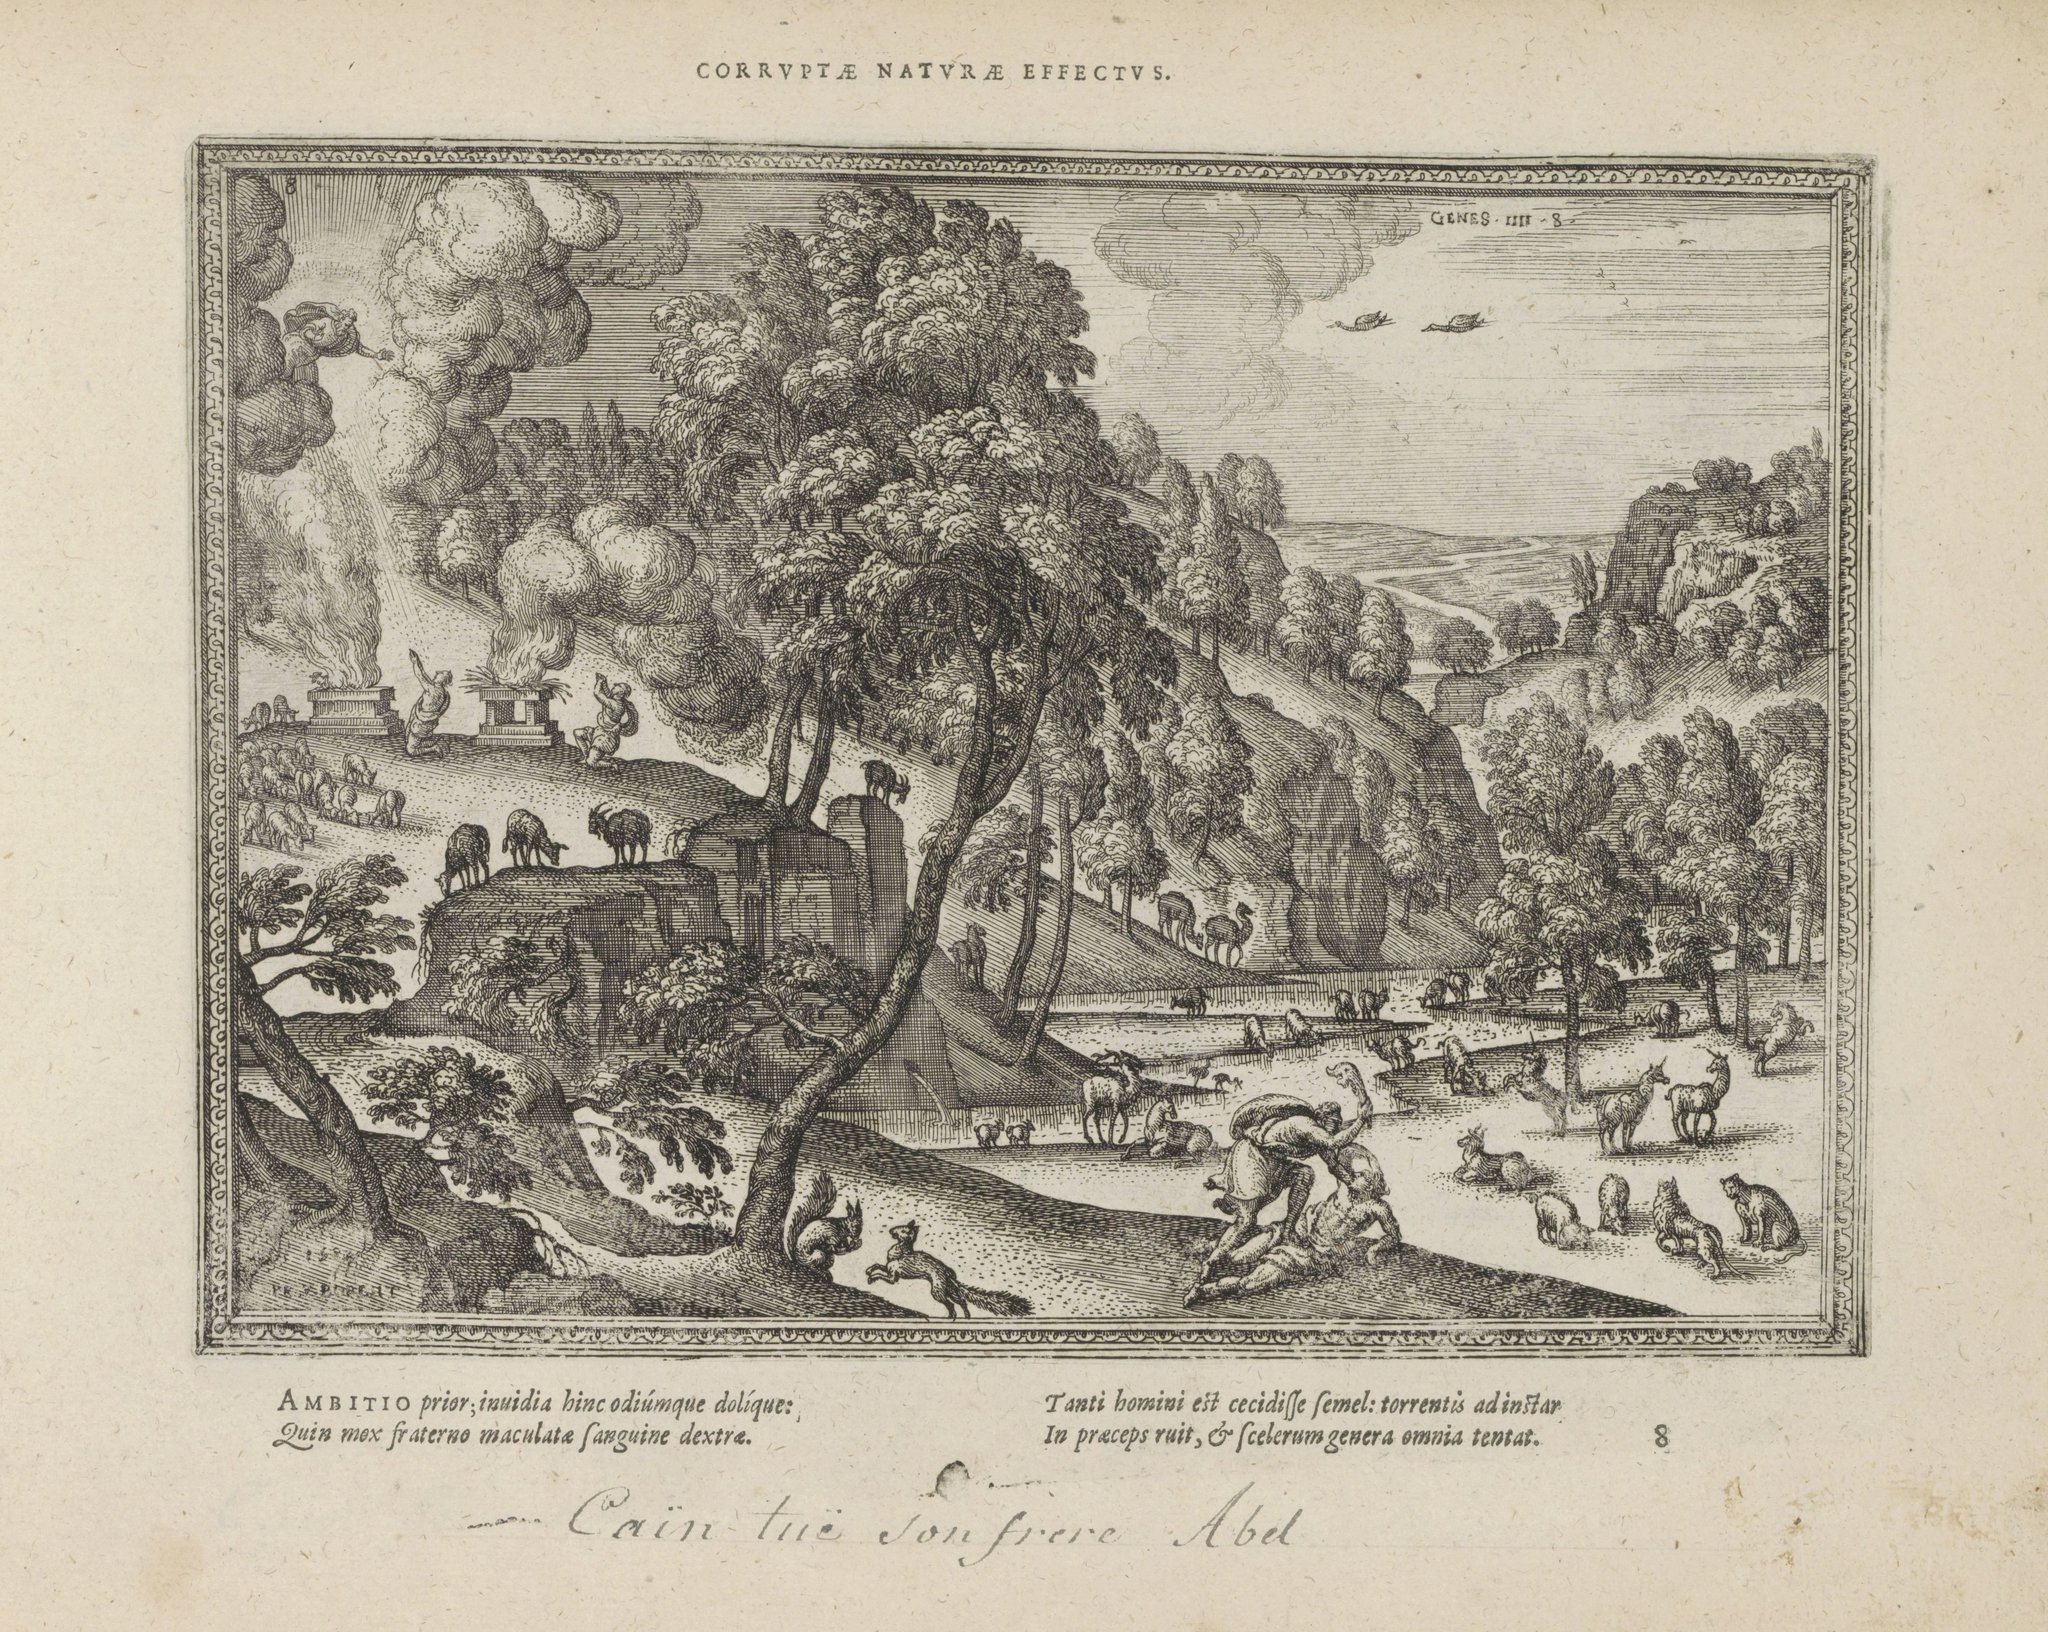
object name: album leaf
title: Emblemata Sacra è praecipuis utriusque testamenti historiis concinnata (Oude Testament)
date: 1582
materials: paper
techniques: etching, letterpress printing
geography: antwerp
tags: animals, the killing of abel: cain slays him with a stone, a club or a jaw-bone, alternatively with a spade or another tool as weapon, the sacrifice of cain and abel: abel offers a lamb, cain usually a sheaf of corn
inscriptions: inscription: ‘Caïn tué son frere Abel’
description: Te midden van een landschap met dieren slaat Kaïn met een opgeheven stuk kaakbeen in op Abel, liggend op de grond (Gen. 4:8). Links op de achtergrond de beide offeraltaren. De rook van het offer van Käin gaat niet omhoog. Het offer van Abel wordt wel door God geaccepteerd. Het licht van God schijnt op Abel, die geknield zijn armen naar de hemel strekt. Met een motto in het Latijn boven de voorstelling en een vierregelig onderschrift in het Latijn onder de prent. De prent maakt deel uit van een album.